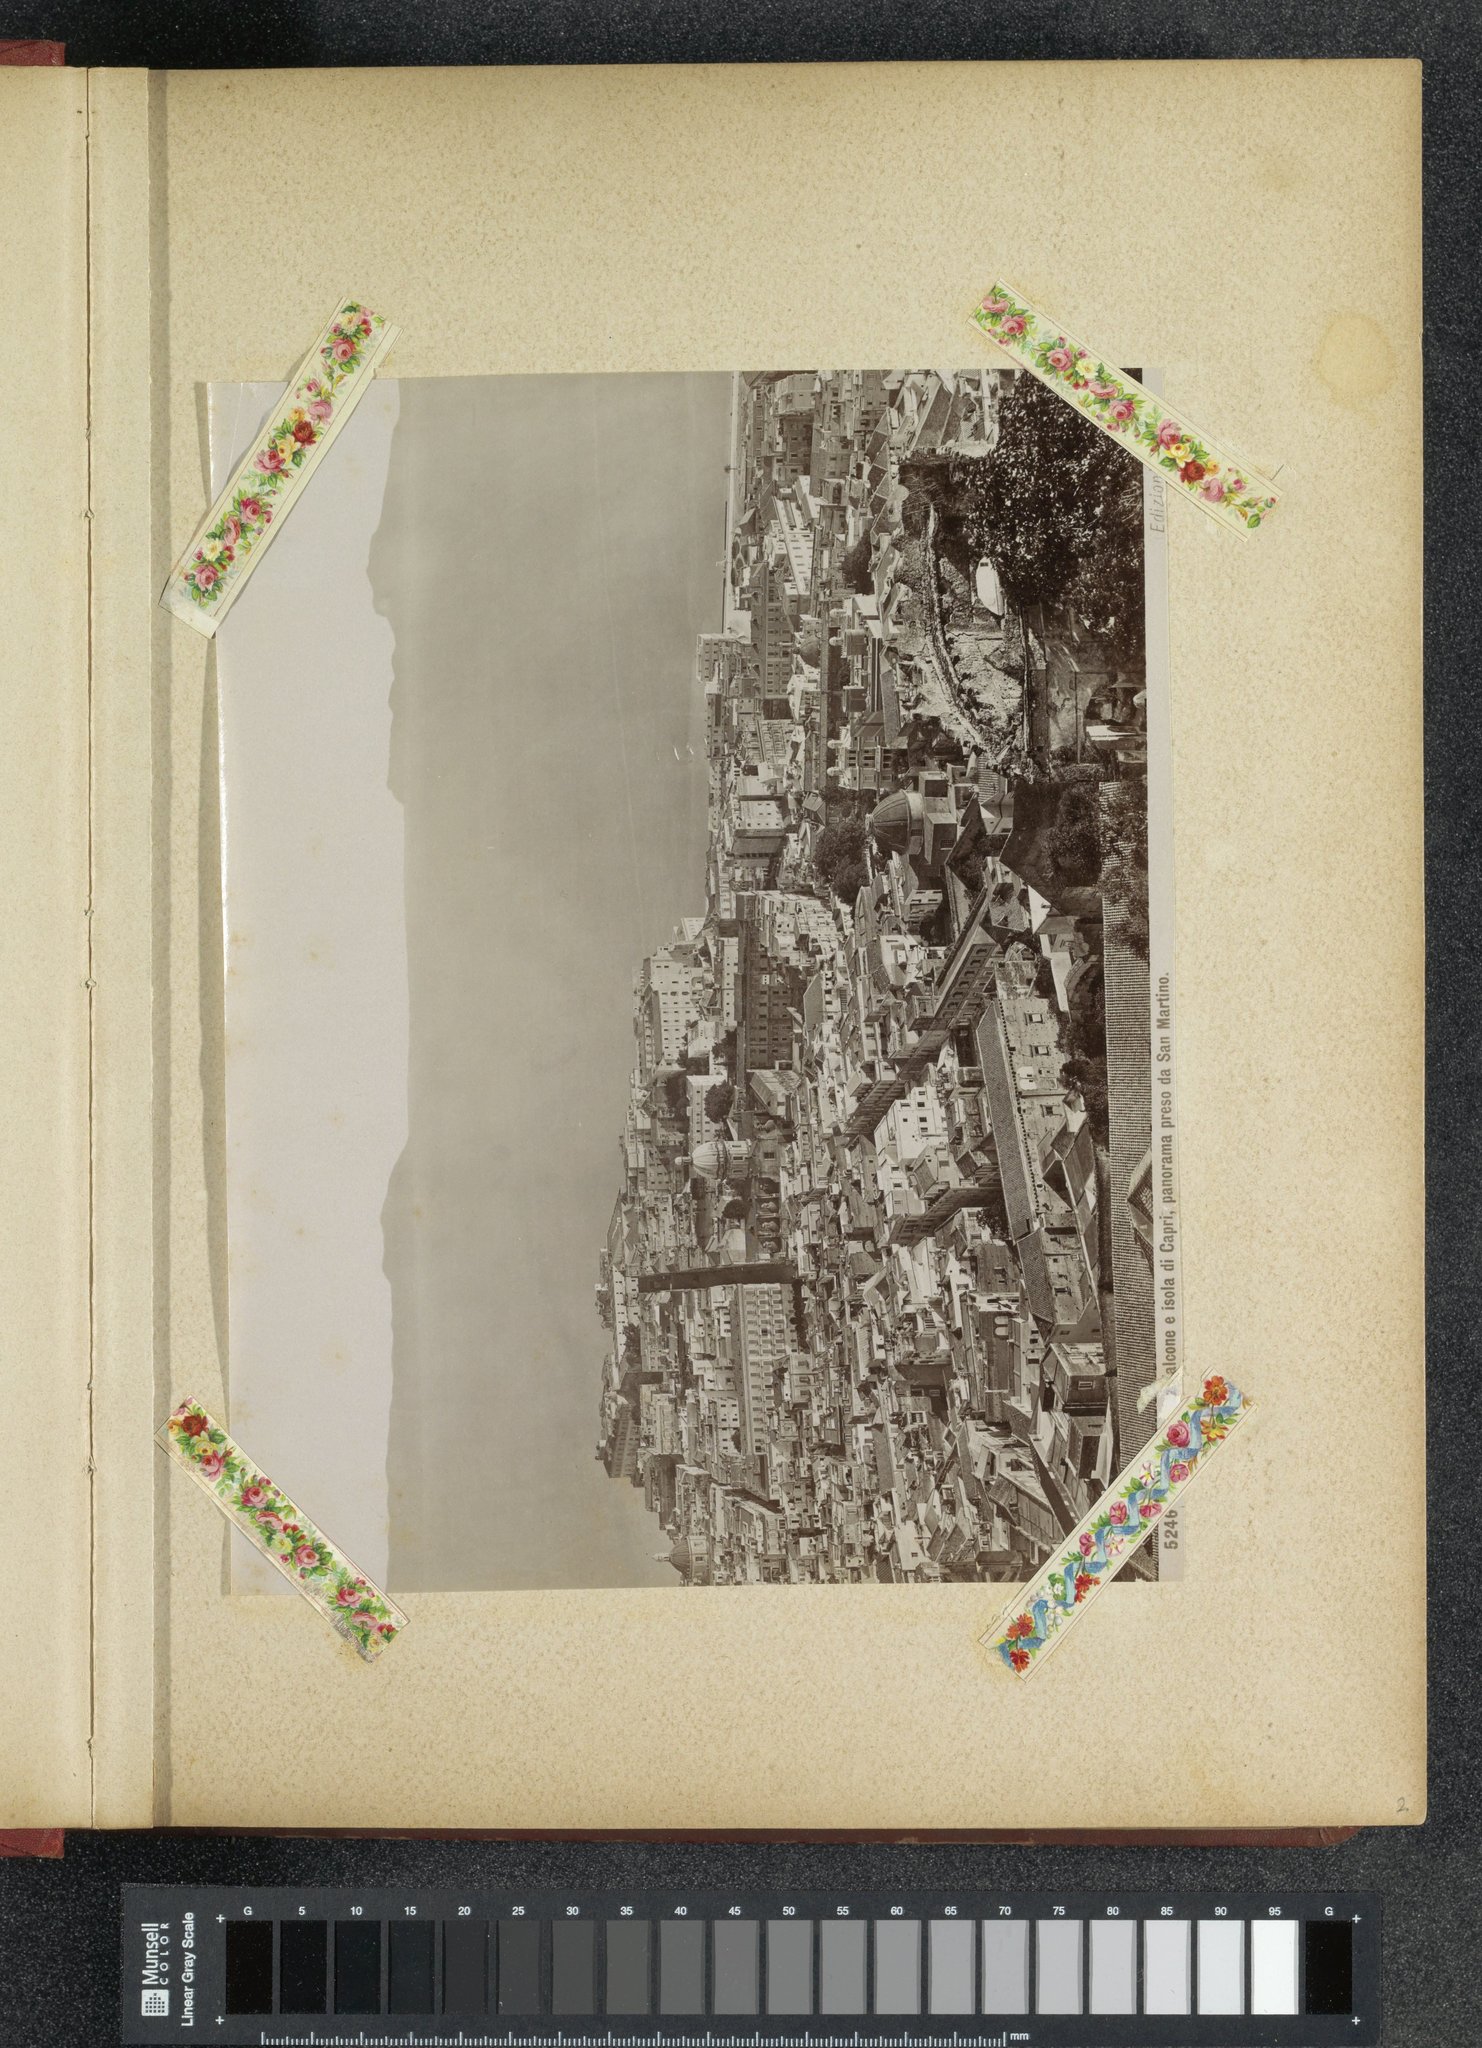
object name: album leaf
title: Napoli. [(...)]alcone e isola di Capri, panorama preso da San Martino.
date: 1870-1900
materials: paper, photographic support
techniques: albumen print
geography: naples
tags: gulf, bay (+ landscape with figures, staffage), island, prospect of city, town panorama, silhouette of city, capri, isola di, naples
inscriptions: negative number: ‘5246’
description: Onderdeel van Reisalbum met foto's van bezienswaardigheden in Italië en Zuid-Frankrijk.